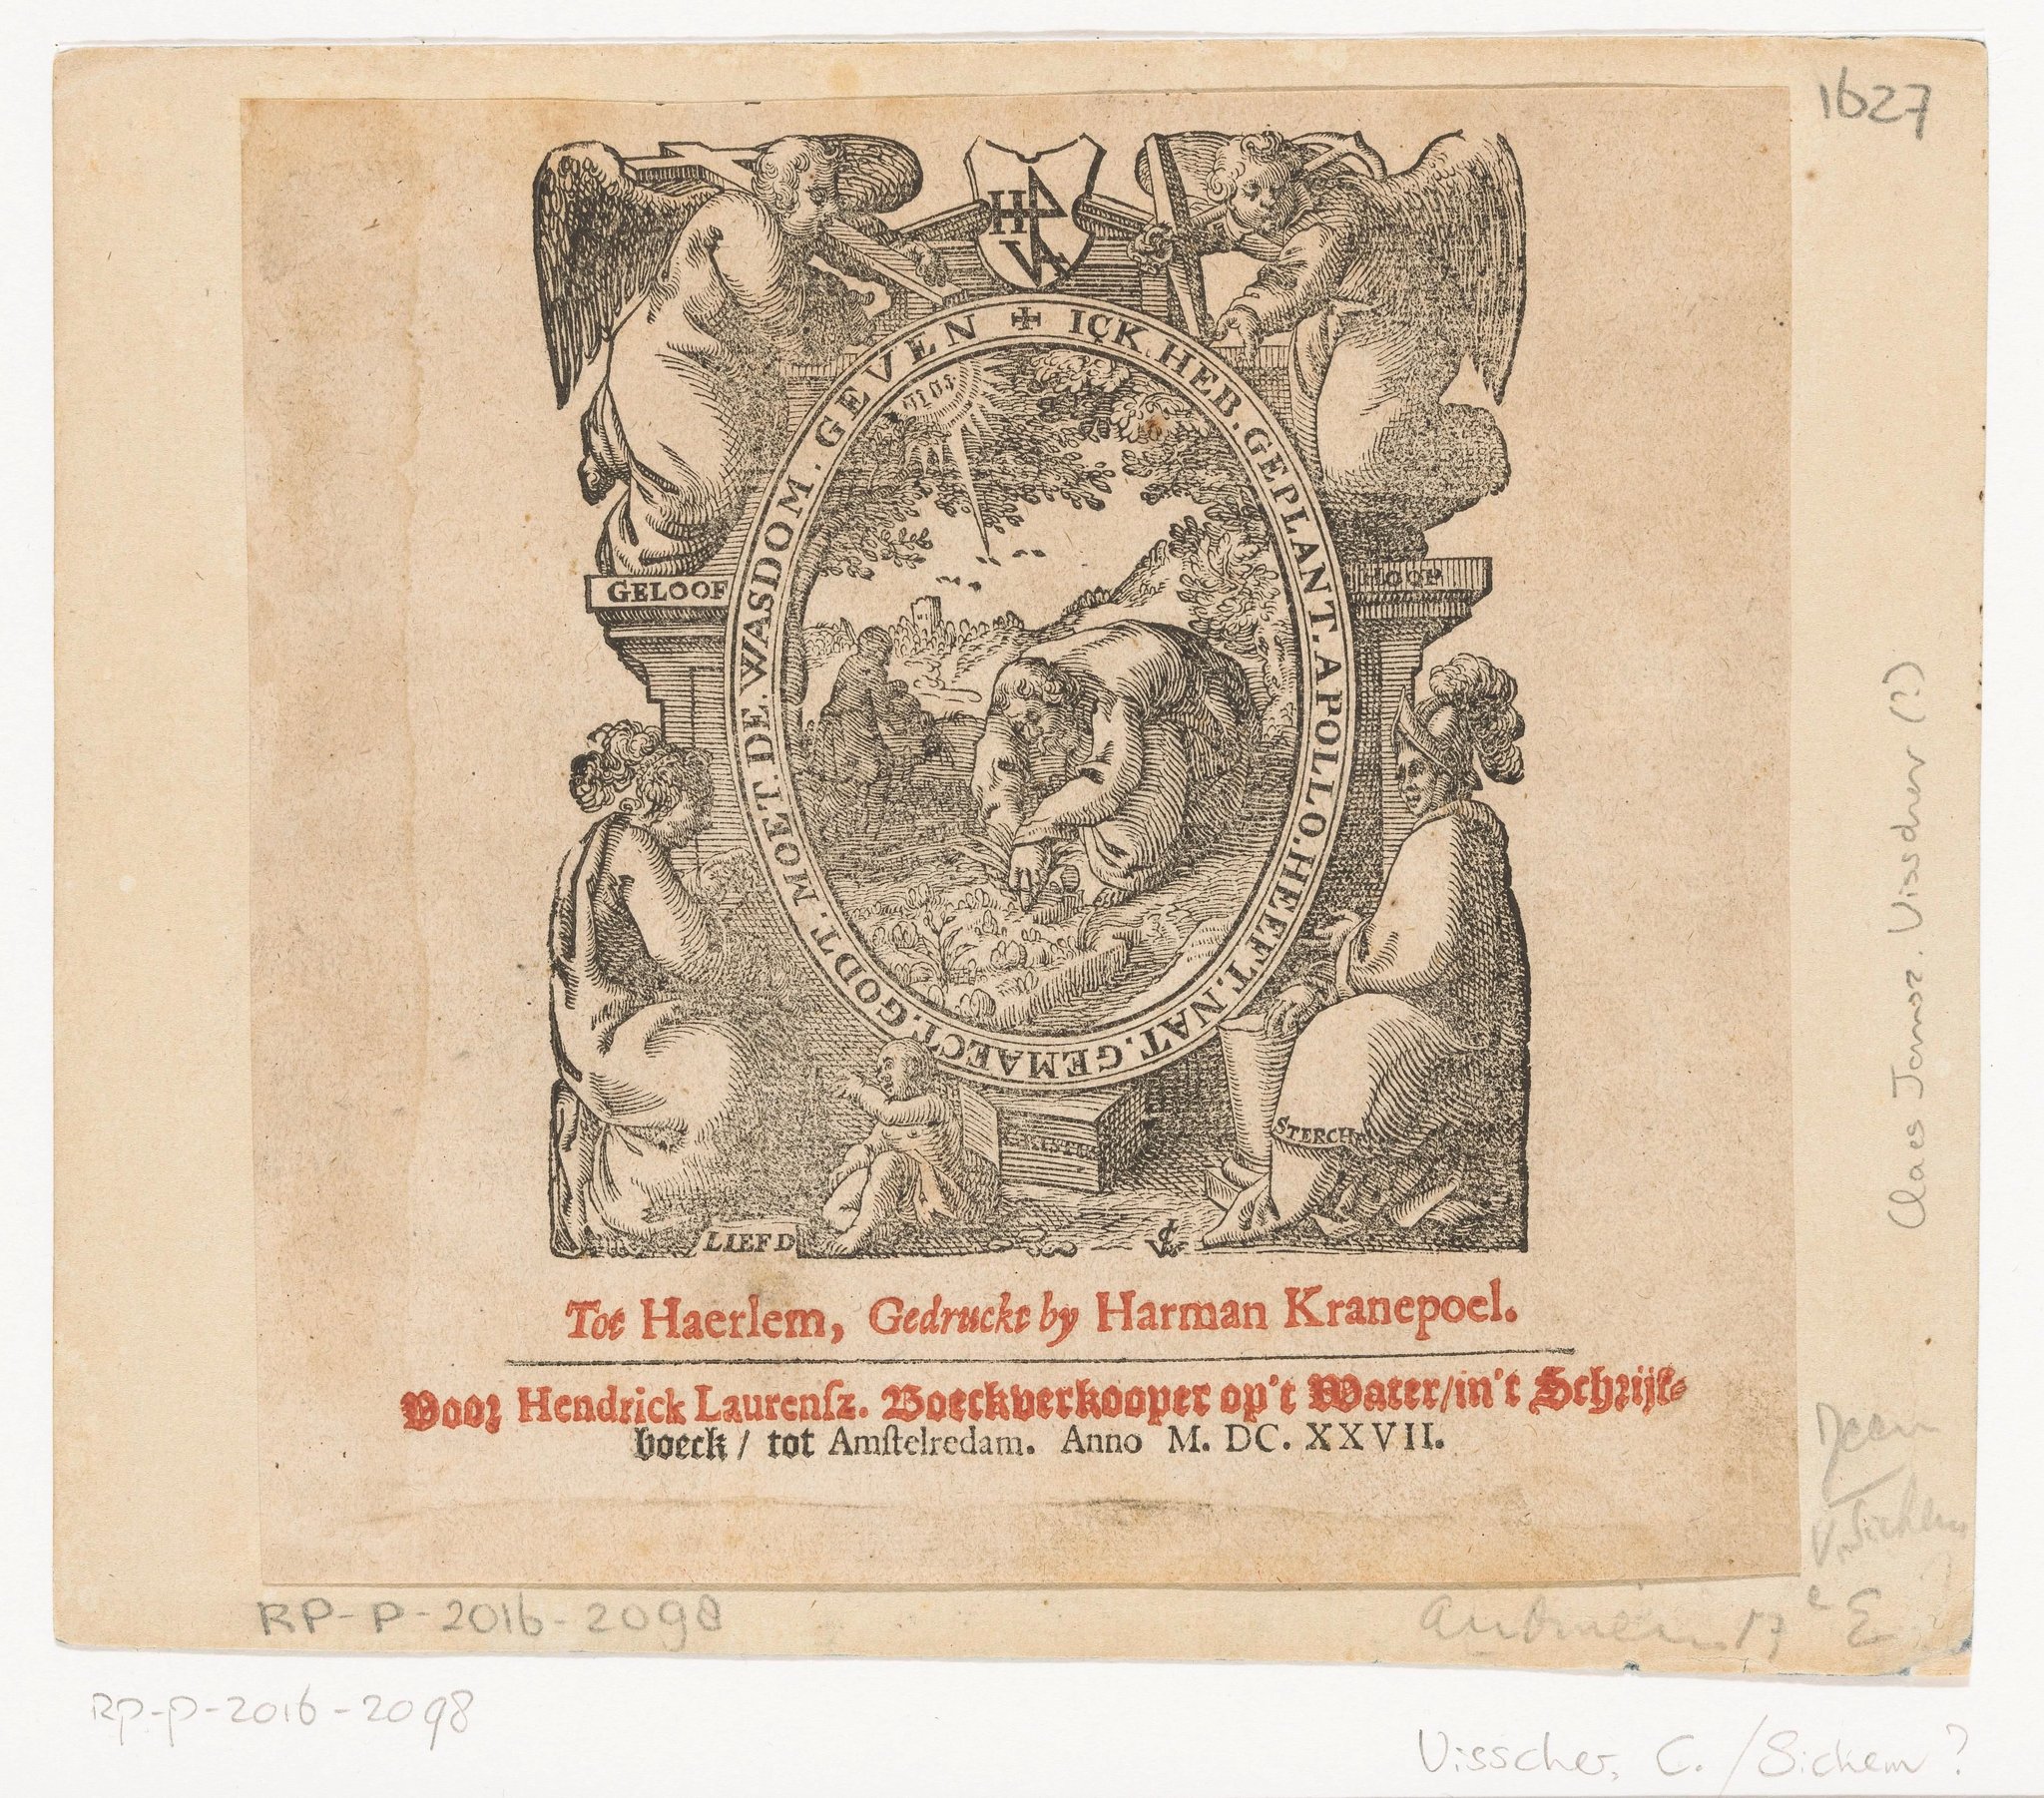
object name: titelblad, titelpagina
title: Man plant gewassen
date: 1627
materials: paper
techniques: letterpress printing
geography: haarlem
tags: the three theological virtues, agriculture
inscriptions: date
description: Ovaal medaillon met een man die gewassen plant. Rondom het motto: Ick heb geplant. Apollo heeft nat gemaect. Godt moet de wasdom geven. In de vier hoeken zitten Geloof met kruis, Hoop met anker, Liefde met kind en Kracht (Sterche) met helm.